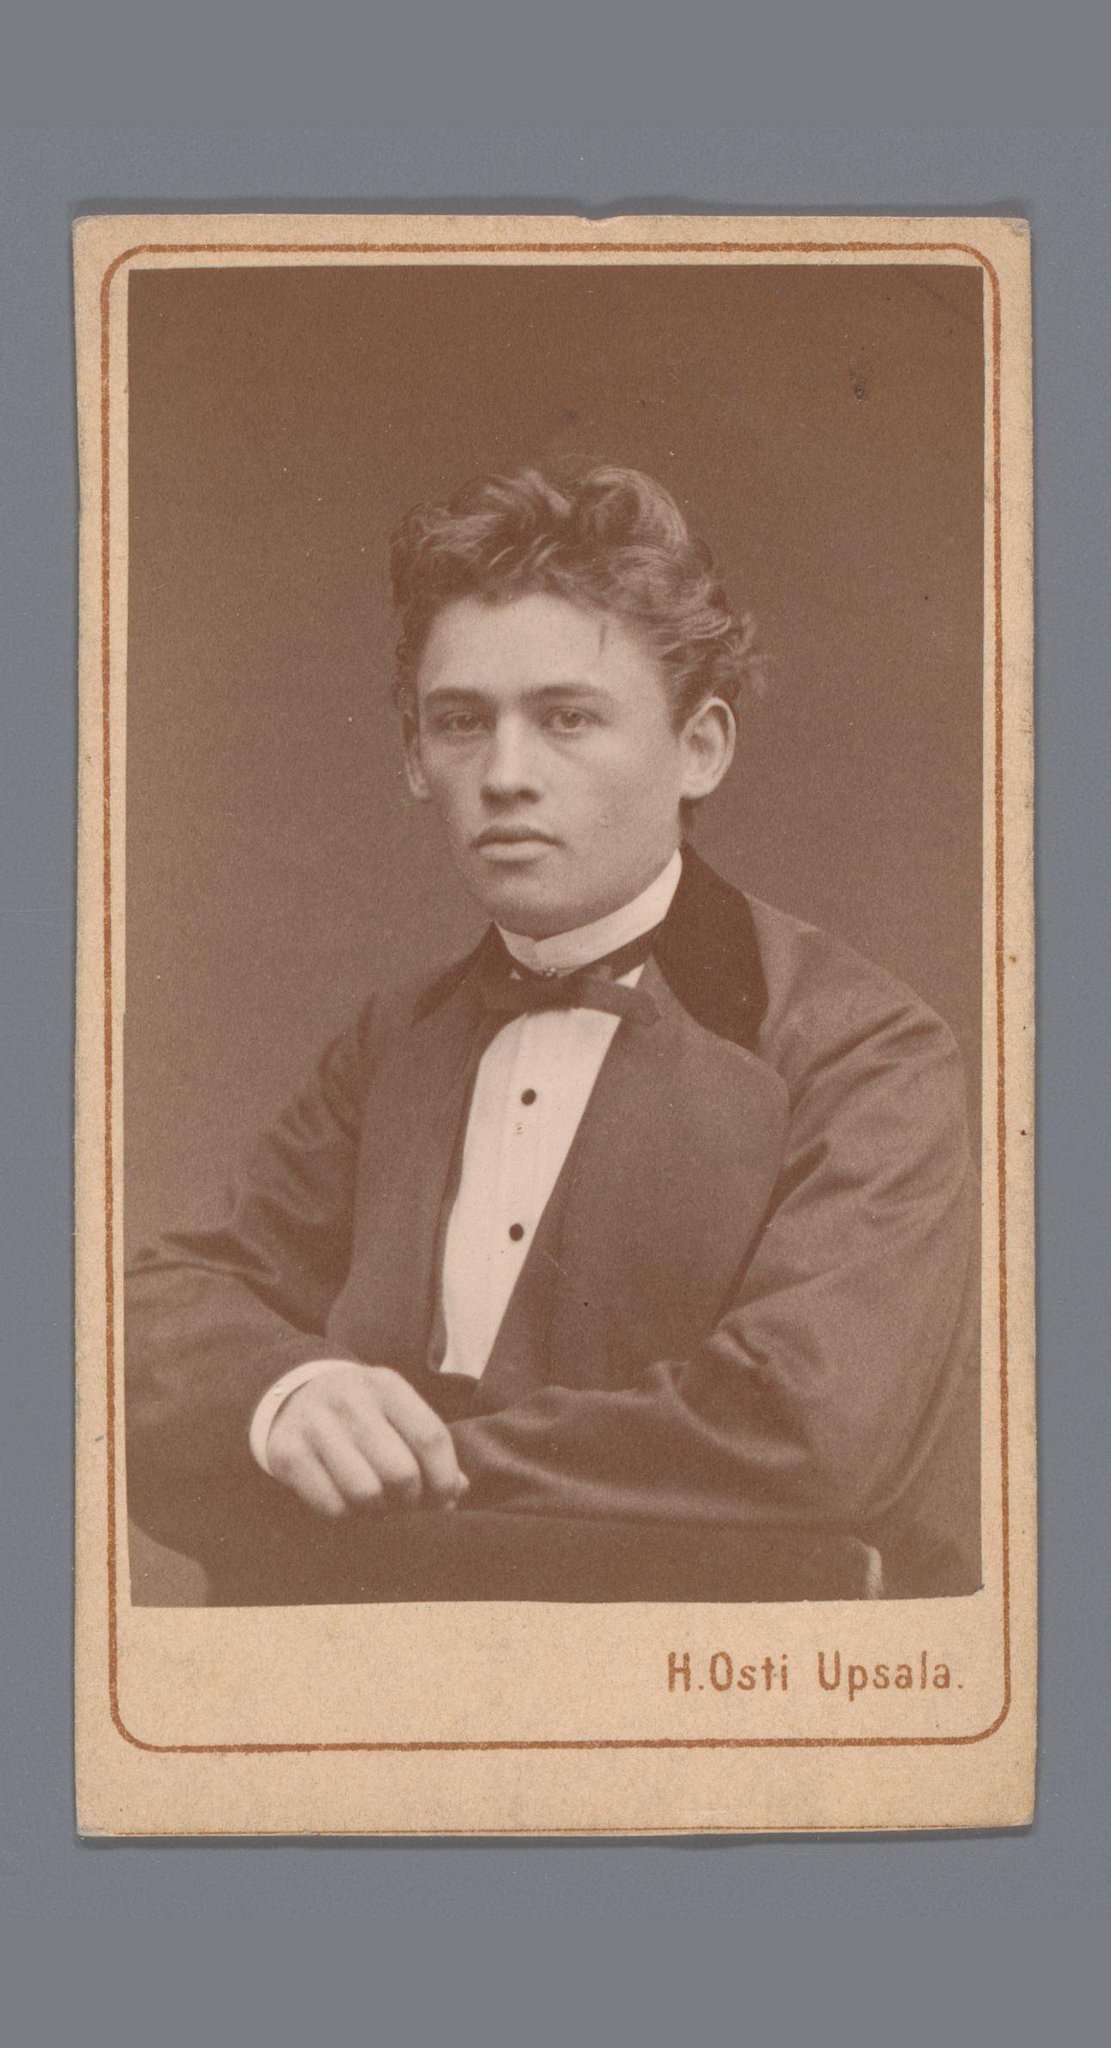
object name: photograph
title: Portret van een onbekende man, aangeduid als Ivar Lundberg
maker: henri ostis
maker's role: fotograaf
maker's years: 1826-1914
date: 1872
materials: cardboard, paper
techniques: albumen print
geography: uppsala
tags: historical persons, youth, adolescent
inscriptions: inscription: ‘Ivar Lundberg/ 1872’, inscription: ‘HENRI OSTIS/ FOTOGRAFI-ATELIÉR/ Copiering efter Taflor, Fotografier m.m./ verkställes i alla storlekar./ UPSALA./ Stora Kungsgatan No. 55./ Plåten förvaras för efterbeställning.’, inscription: ‘1.-’